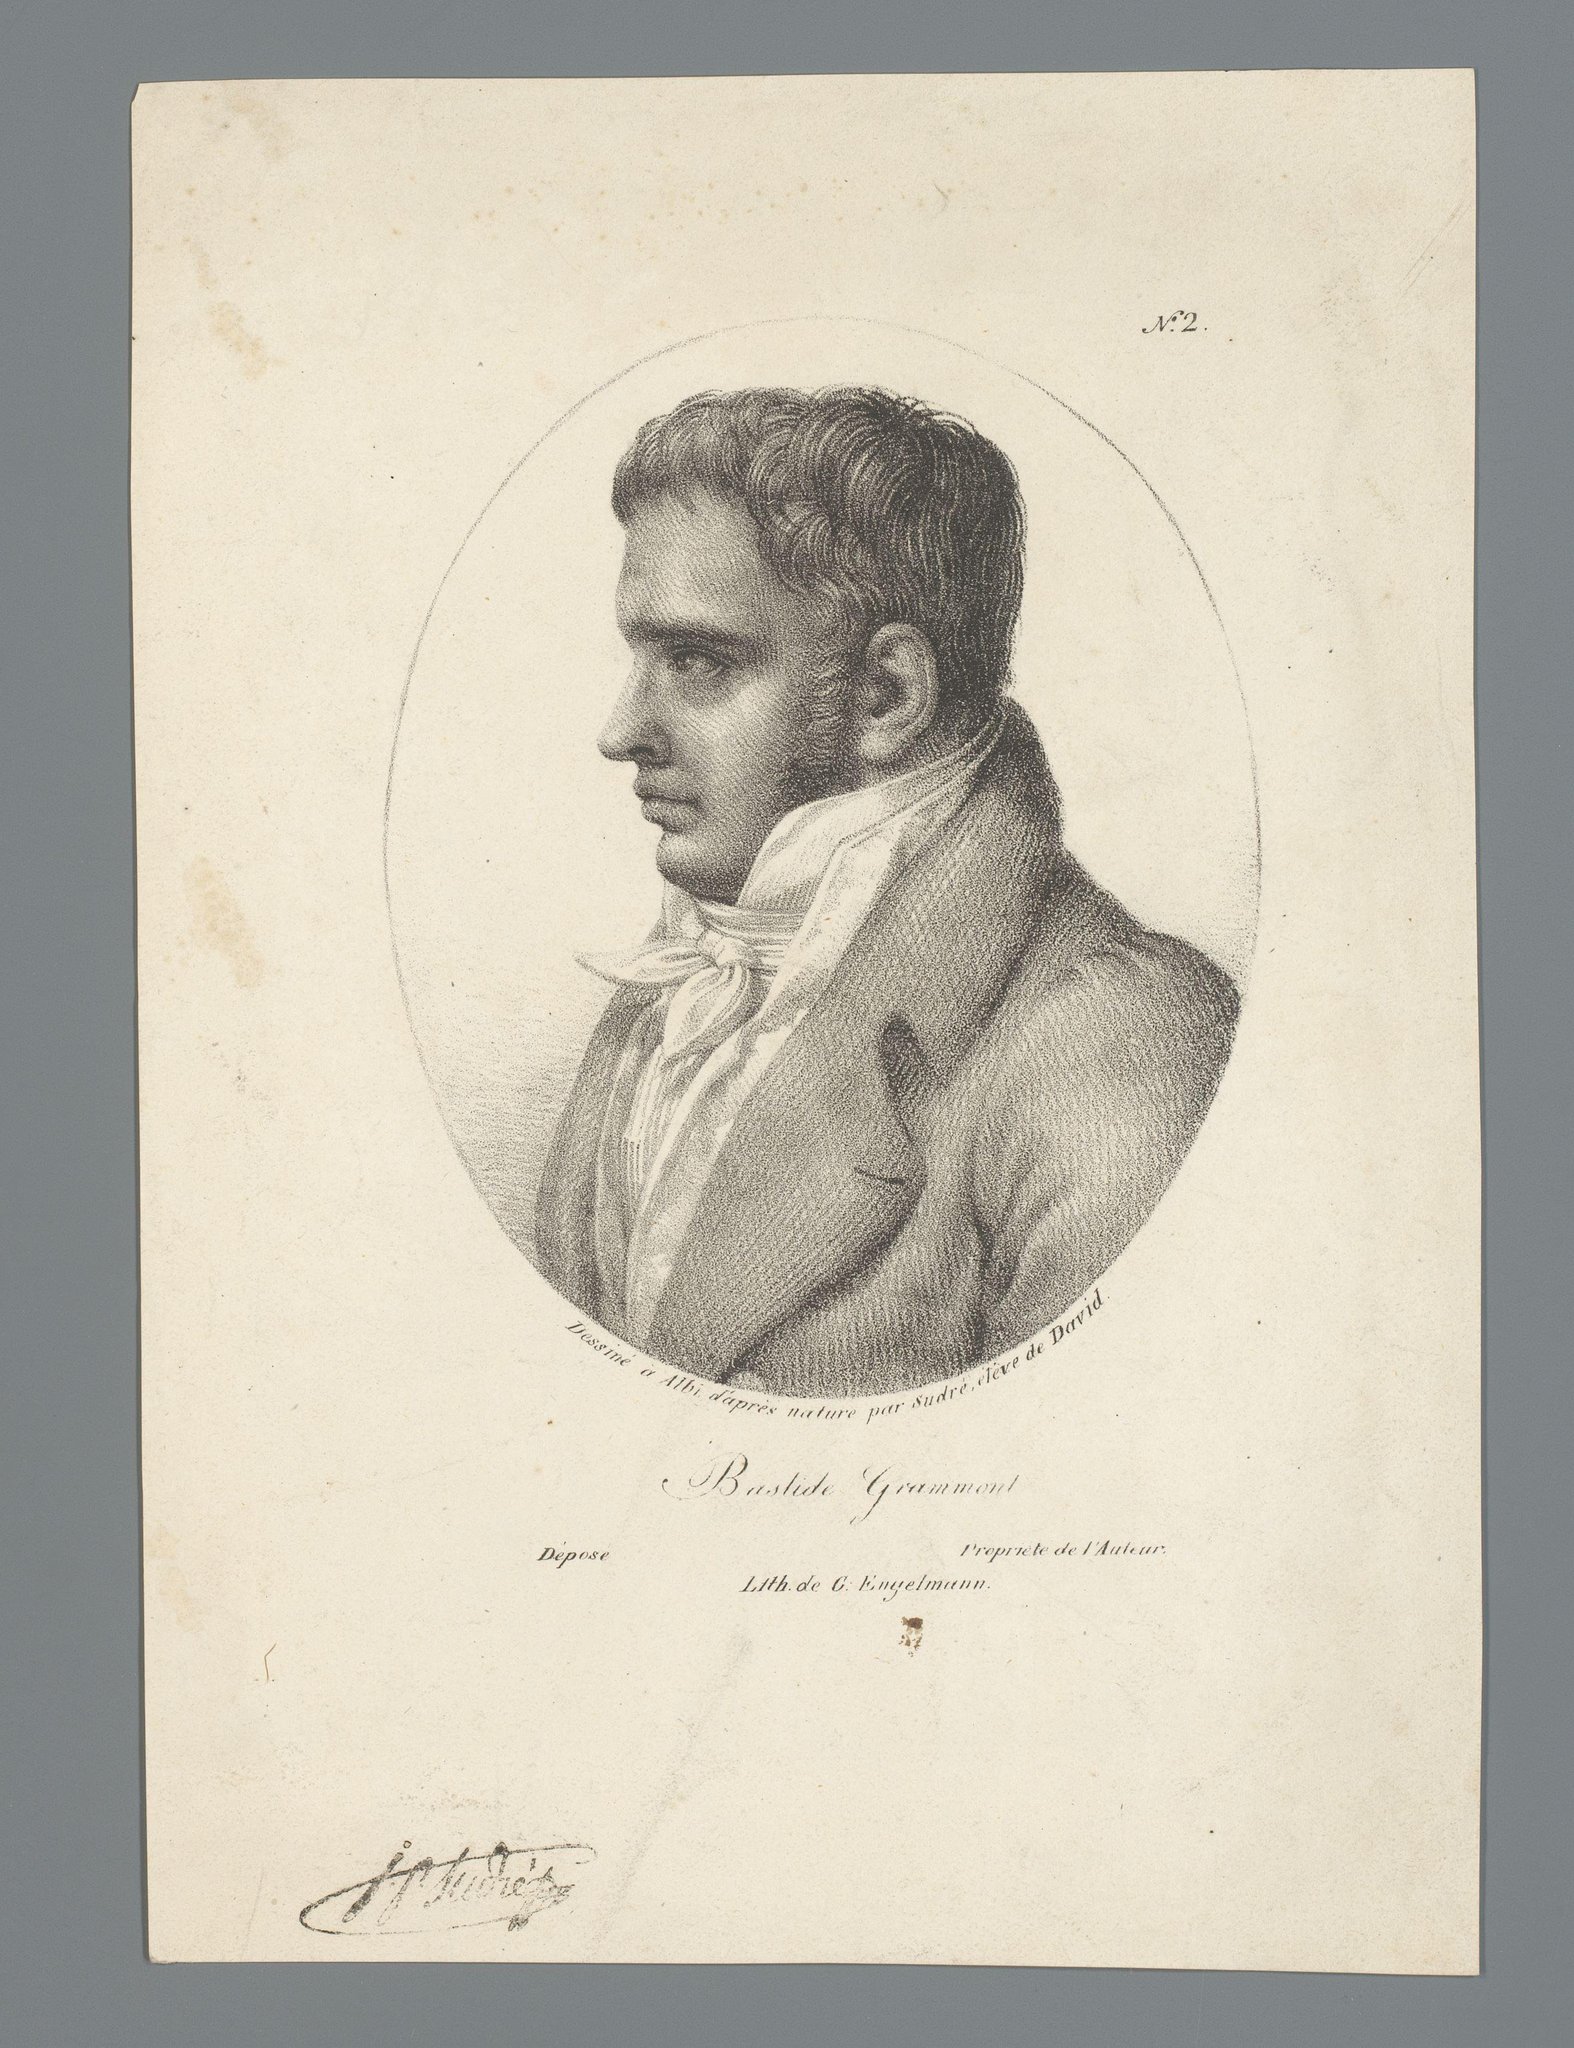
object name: print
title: Hoofdpersonages in de affaire-Fualdès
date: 1818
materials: paper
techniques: lithograph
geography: paris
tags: historical persons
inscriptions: stamp: Lugt 2325b, collector's mark: Lugt 2228